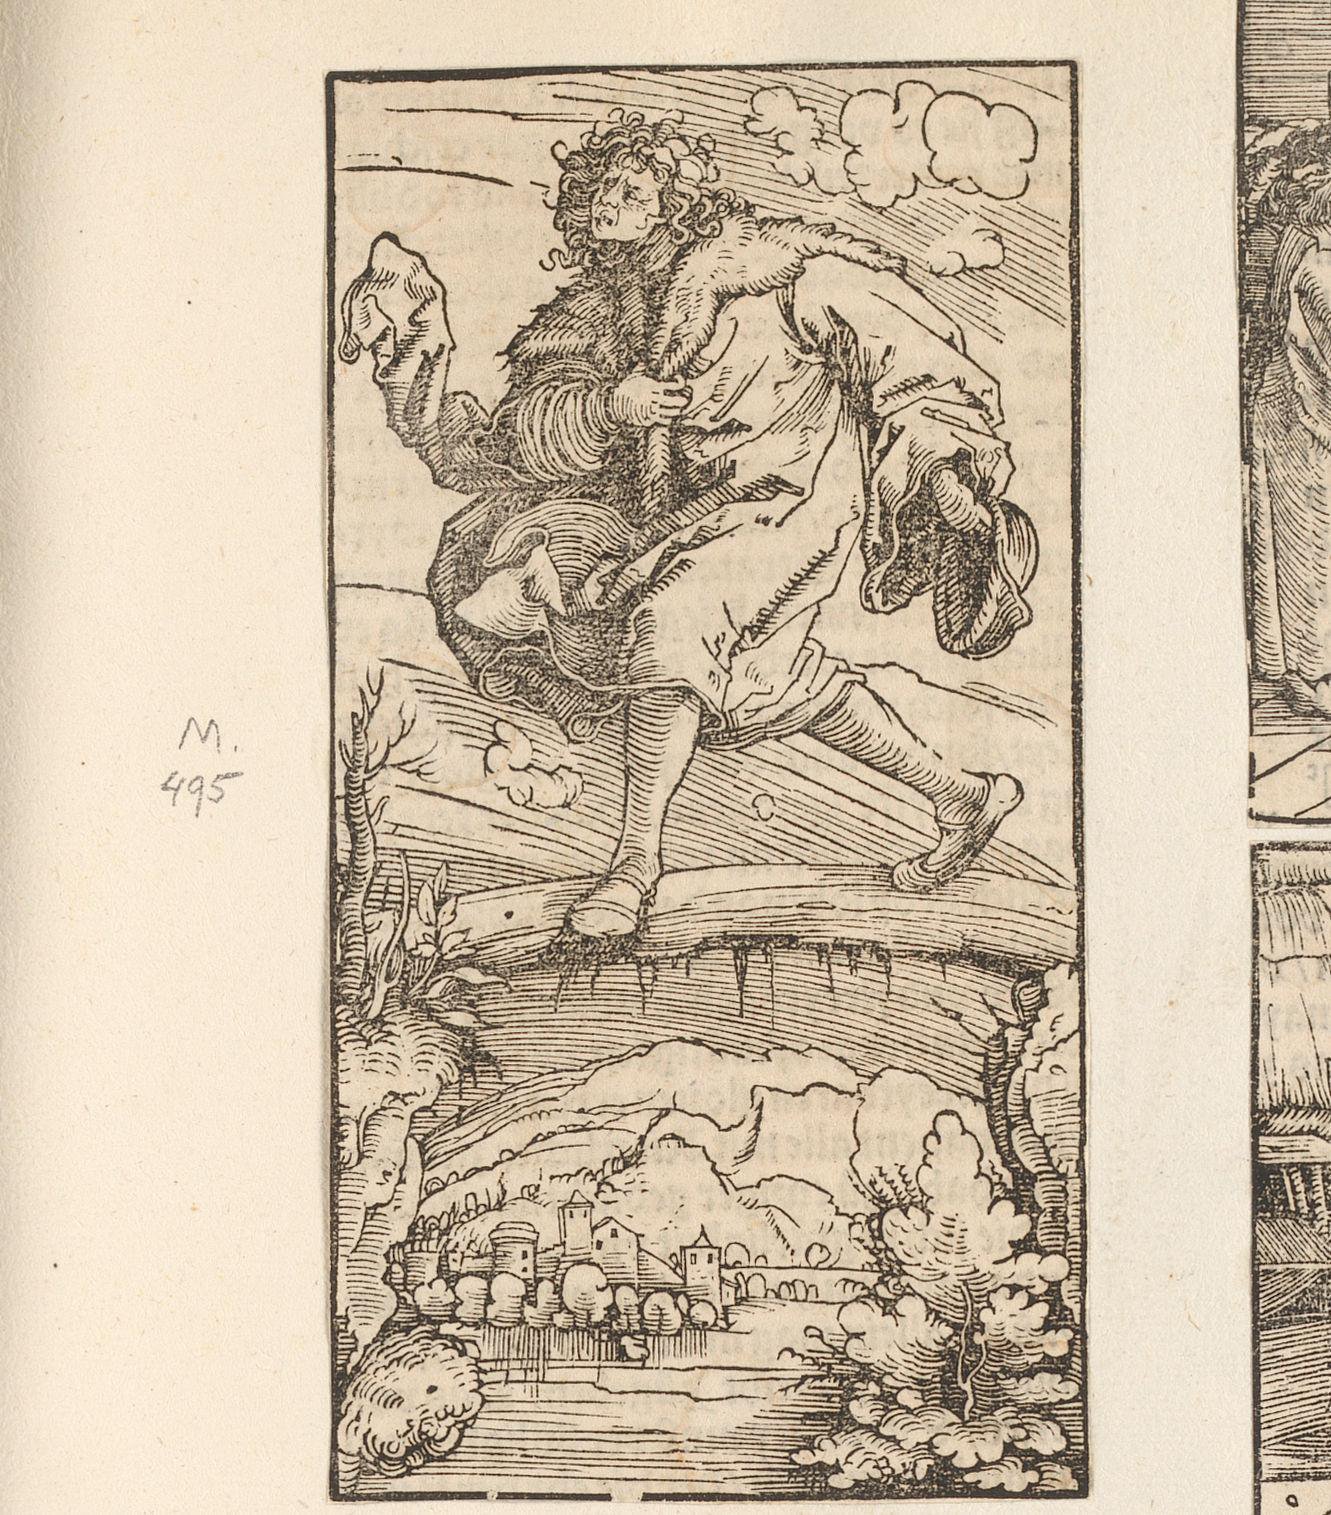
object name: print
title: Pelgrim loopt over een brug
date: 1514-1531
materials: paper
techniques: letterpress printing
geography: augsburg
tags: pilgrimage, pilgrim(s) under way, bridge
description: Deze prent is gebruikt in: Petrarca, Francesco. Von der Artzney bayder Glück, des guten und widerwertigen: unnd weß sich ain yeder inn Gelück und Unglück halten sol (...). Augsburg: Heinrich Steiner, 1532. Deze uitgave is ook bekend onder de titel 'Trostspiegel in Glück und Unglück'. Deze prent is gebruikt in: Cicero, Marcus Tulius. Officia M.T.C. Ein Buch so Marcus Tullius Cicero der Römer zu seynem (...). [Vertaald uit het Latijn door] Johann von Schwarzenberg. Augsburg: Heinrich Steiner, 1531.